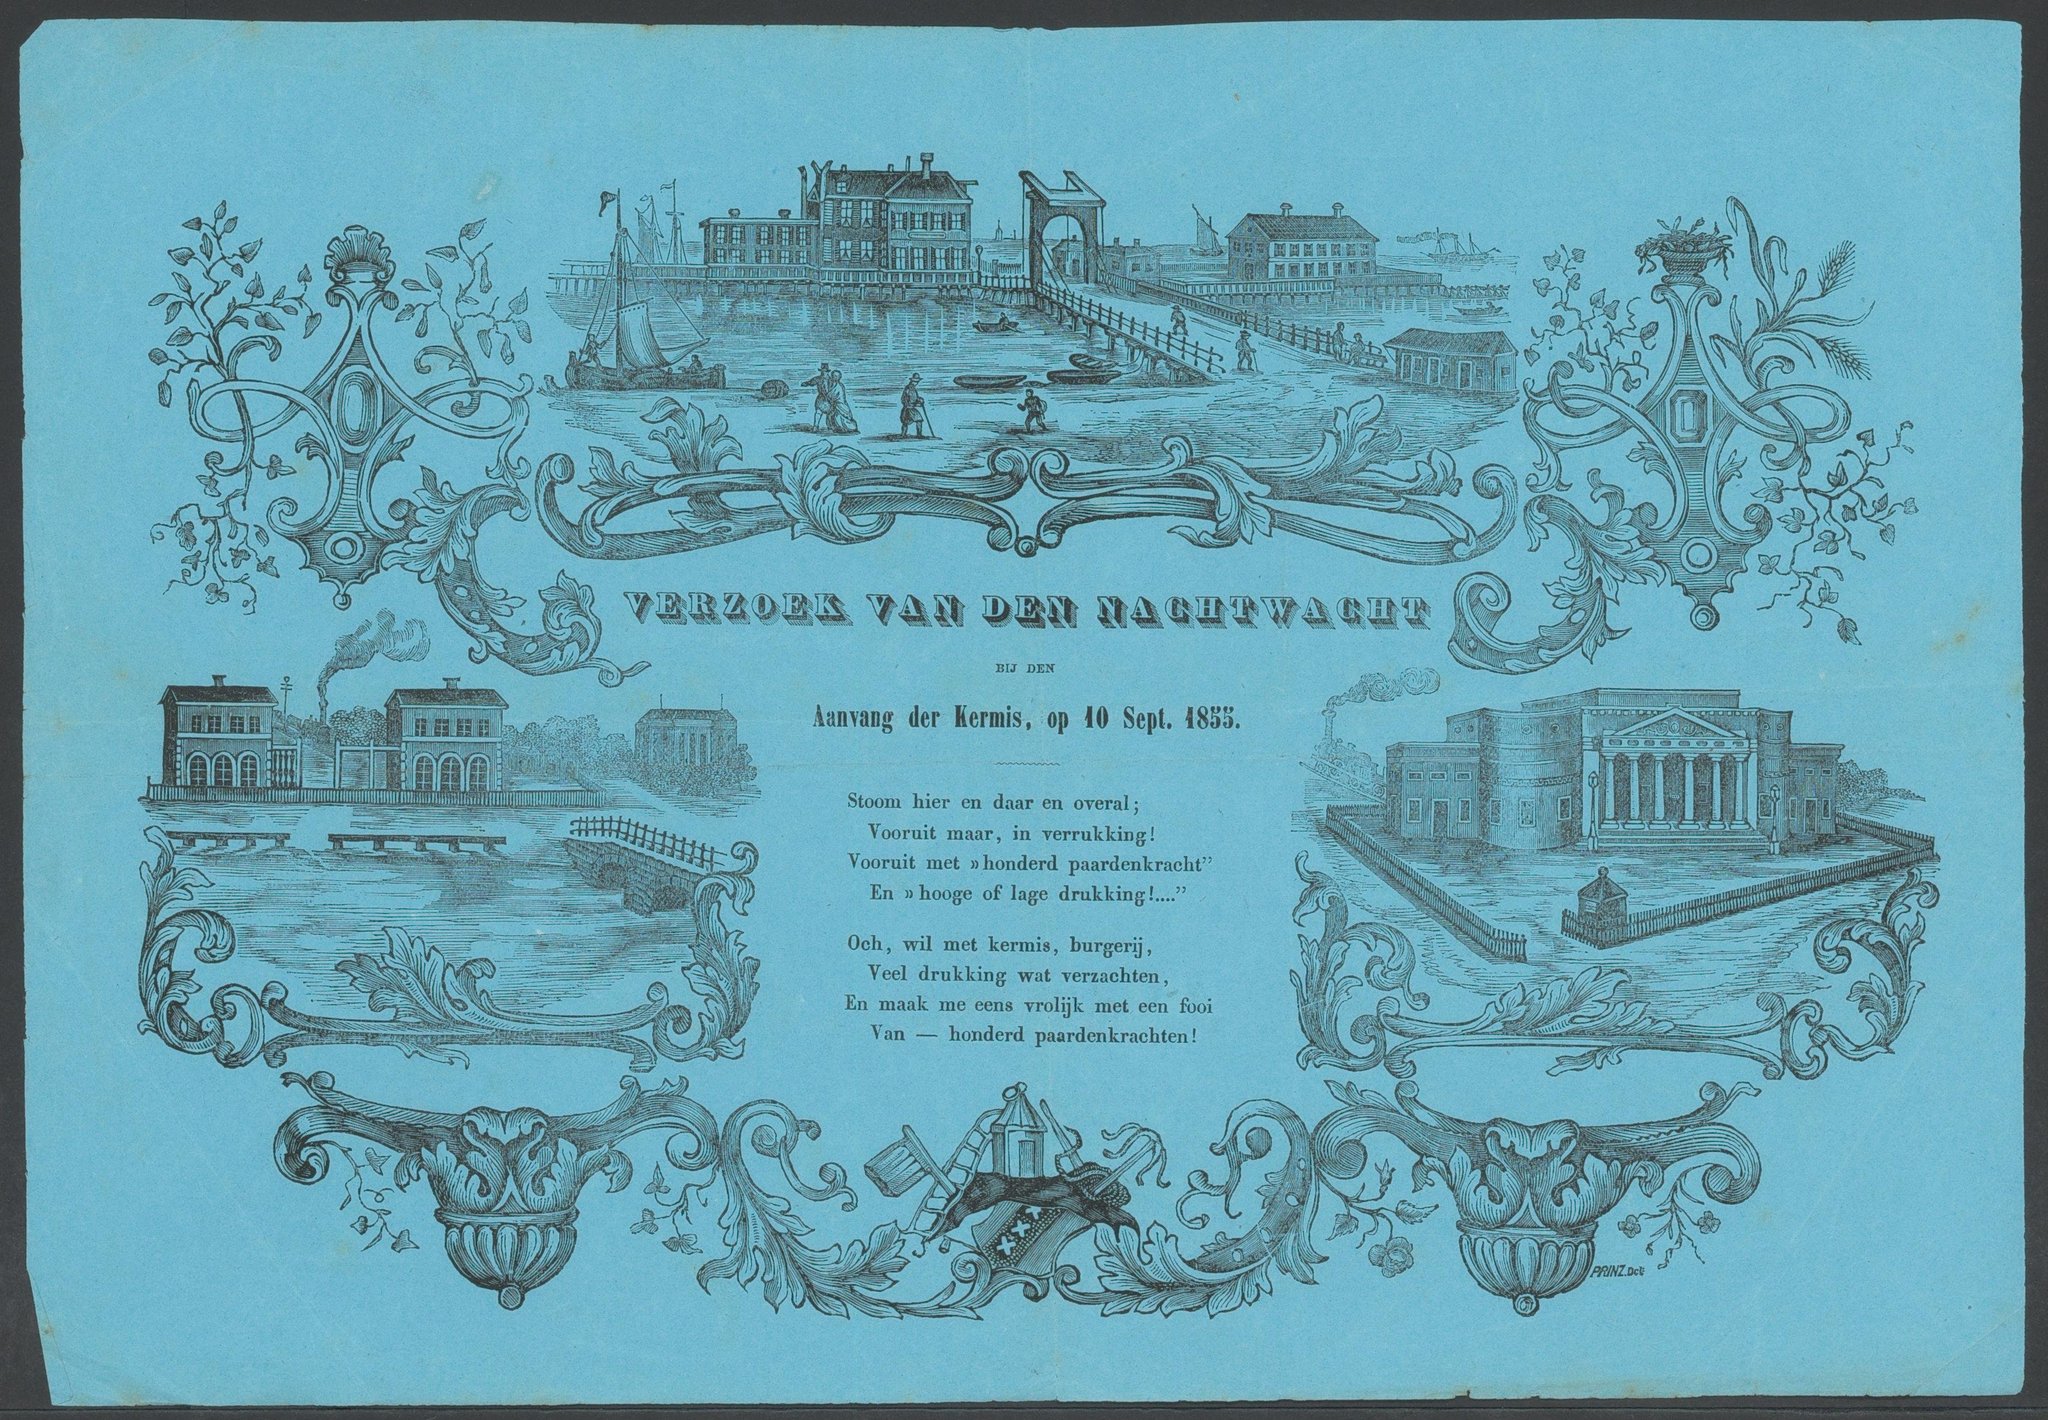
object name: print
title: Kermisprent van de Amsterdamse nachtwacht voor het jaar 1855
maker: friedrich robert prinz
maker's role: print maker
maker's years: 1820-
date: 1855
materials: paper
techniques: letterpress printing, engraving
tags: night patrol, amsterdam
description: Kermisprent van de Amsterdamse nachtwacht (ratelwacht), september 1855. Centraal een gedicht met daar omheen de Nieuwe stadsherberg, station Rhijnspoor en station Willemspoort. Onderwerpsrubrieken binnen de Atlas Zeden en Gewoonten: Zeden en gewoonten in engeren zin, Volksleven, Volksbladen, Nieuwjaars- en Kerstwenschen, Amsterdam.